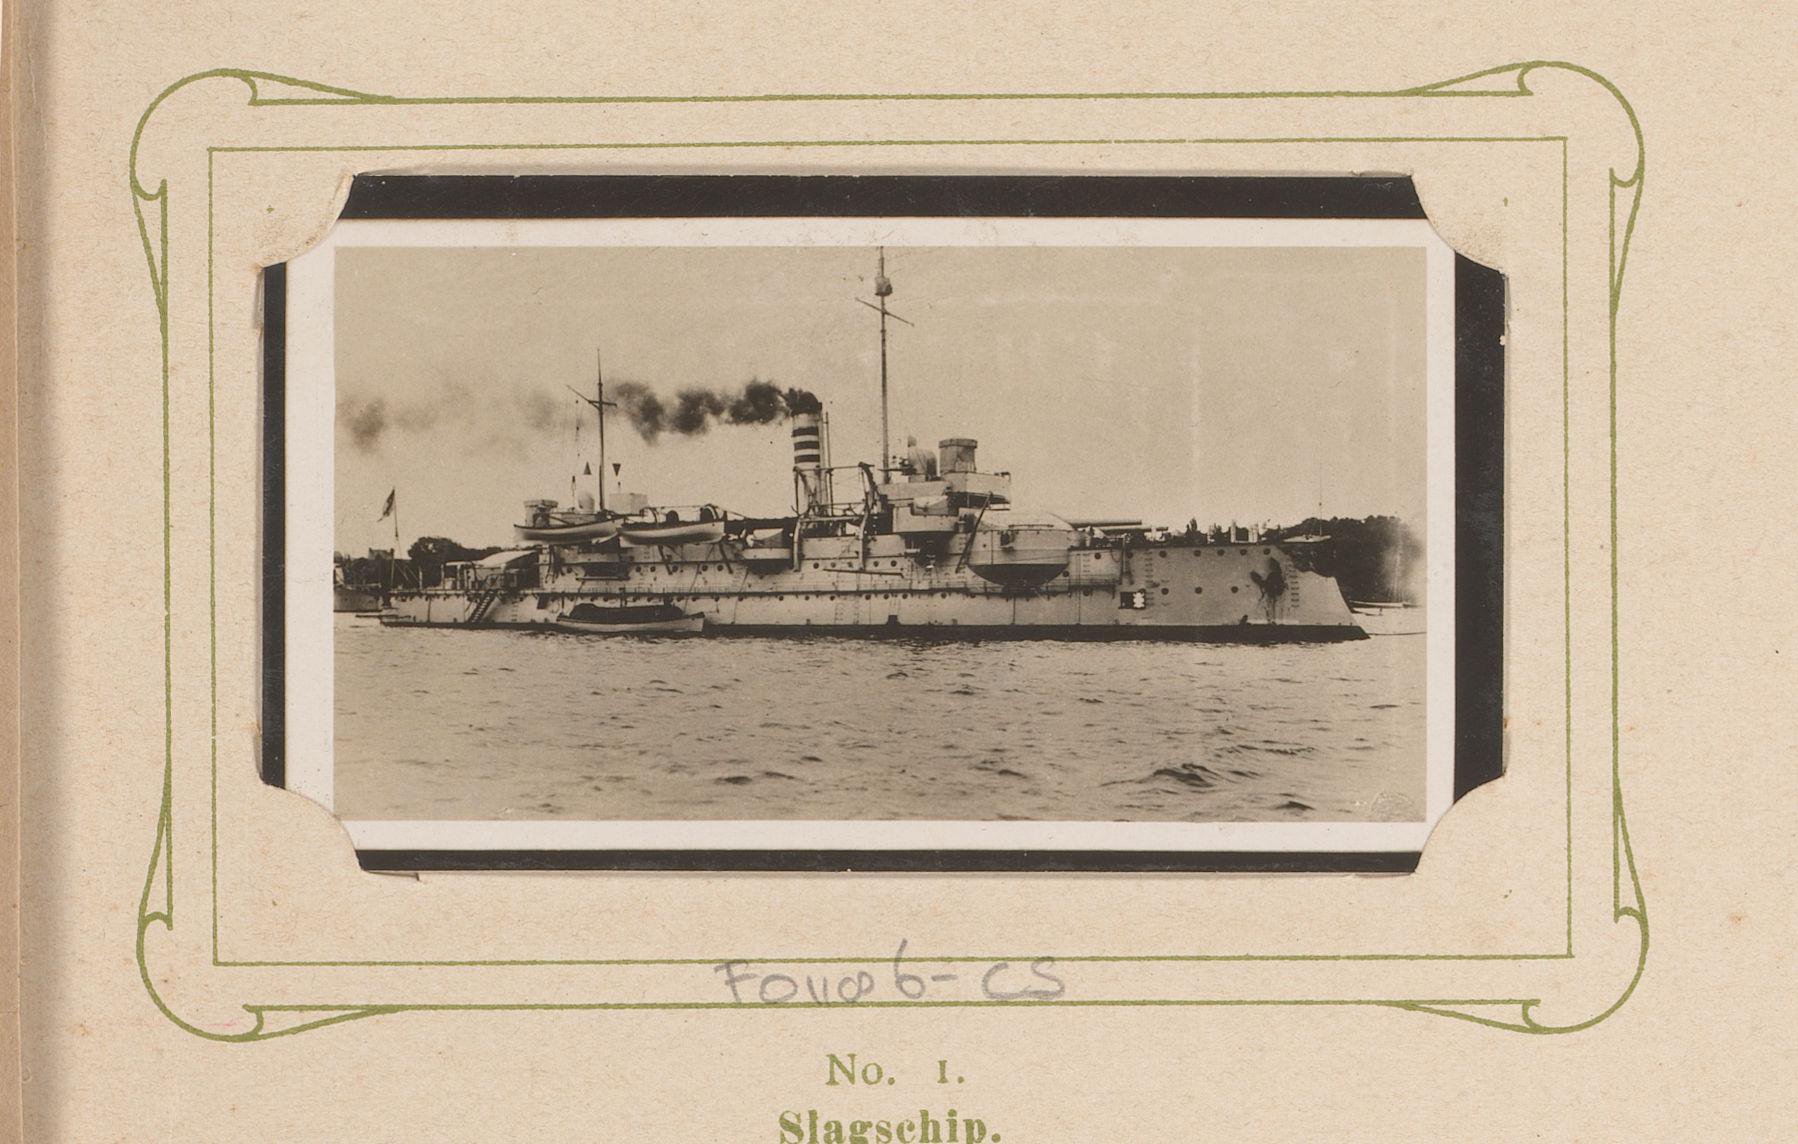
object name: photograph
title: Slagschip te water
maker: Anonymous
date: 1904-1905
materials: photographic support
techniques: gelatin silver print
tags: warfare; military affairs (+ motor ships)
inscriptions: inscription: ‘No. 1./ Slagschip.’